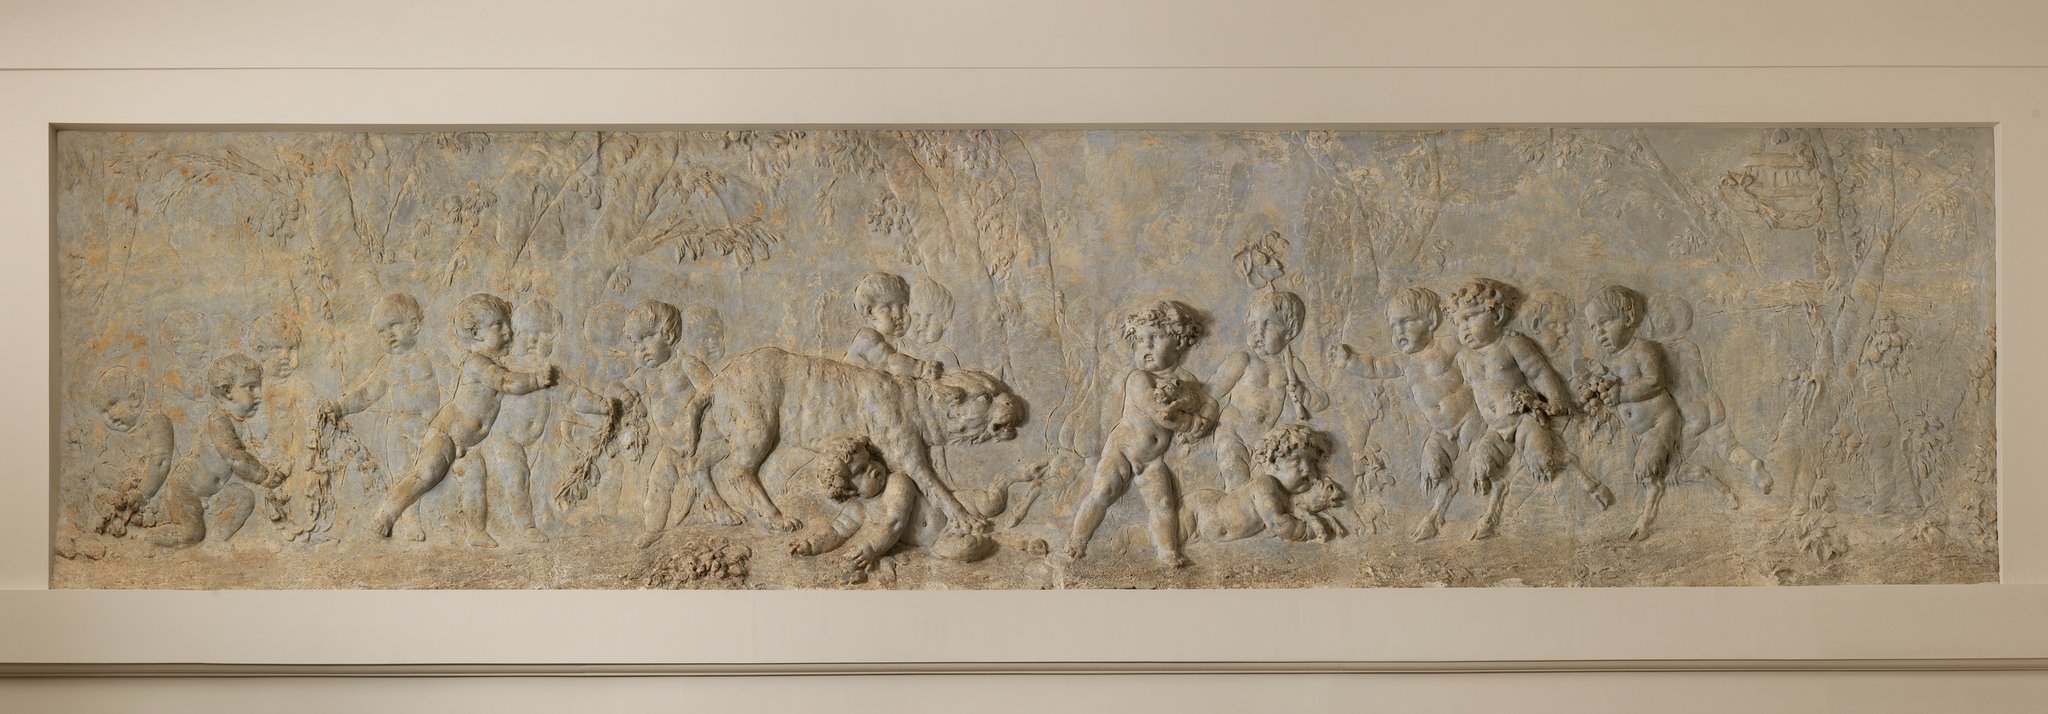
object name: frieze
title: Children and satyr children stealing the cubs of a pantheress (part of a group)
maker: clodion (claude michel)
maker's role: artist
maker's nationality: french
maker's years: 1738-1814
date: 1781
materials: plaster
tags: animals,children,satyrs